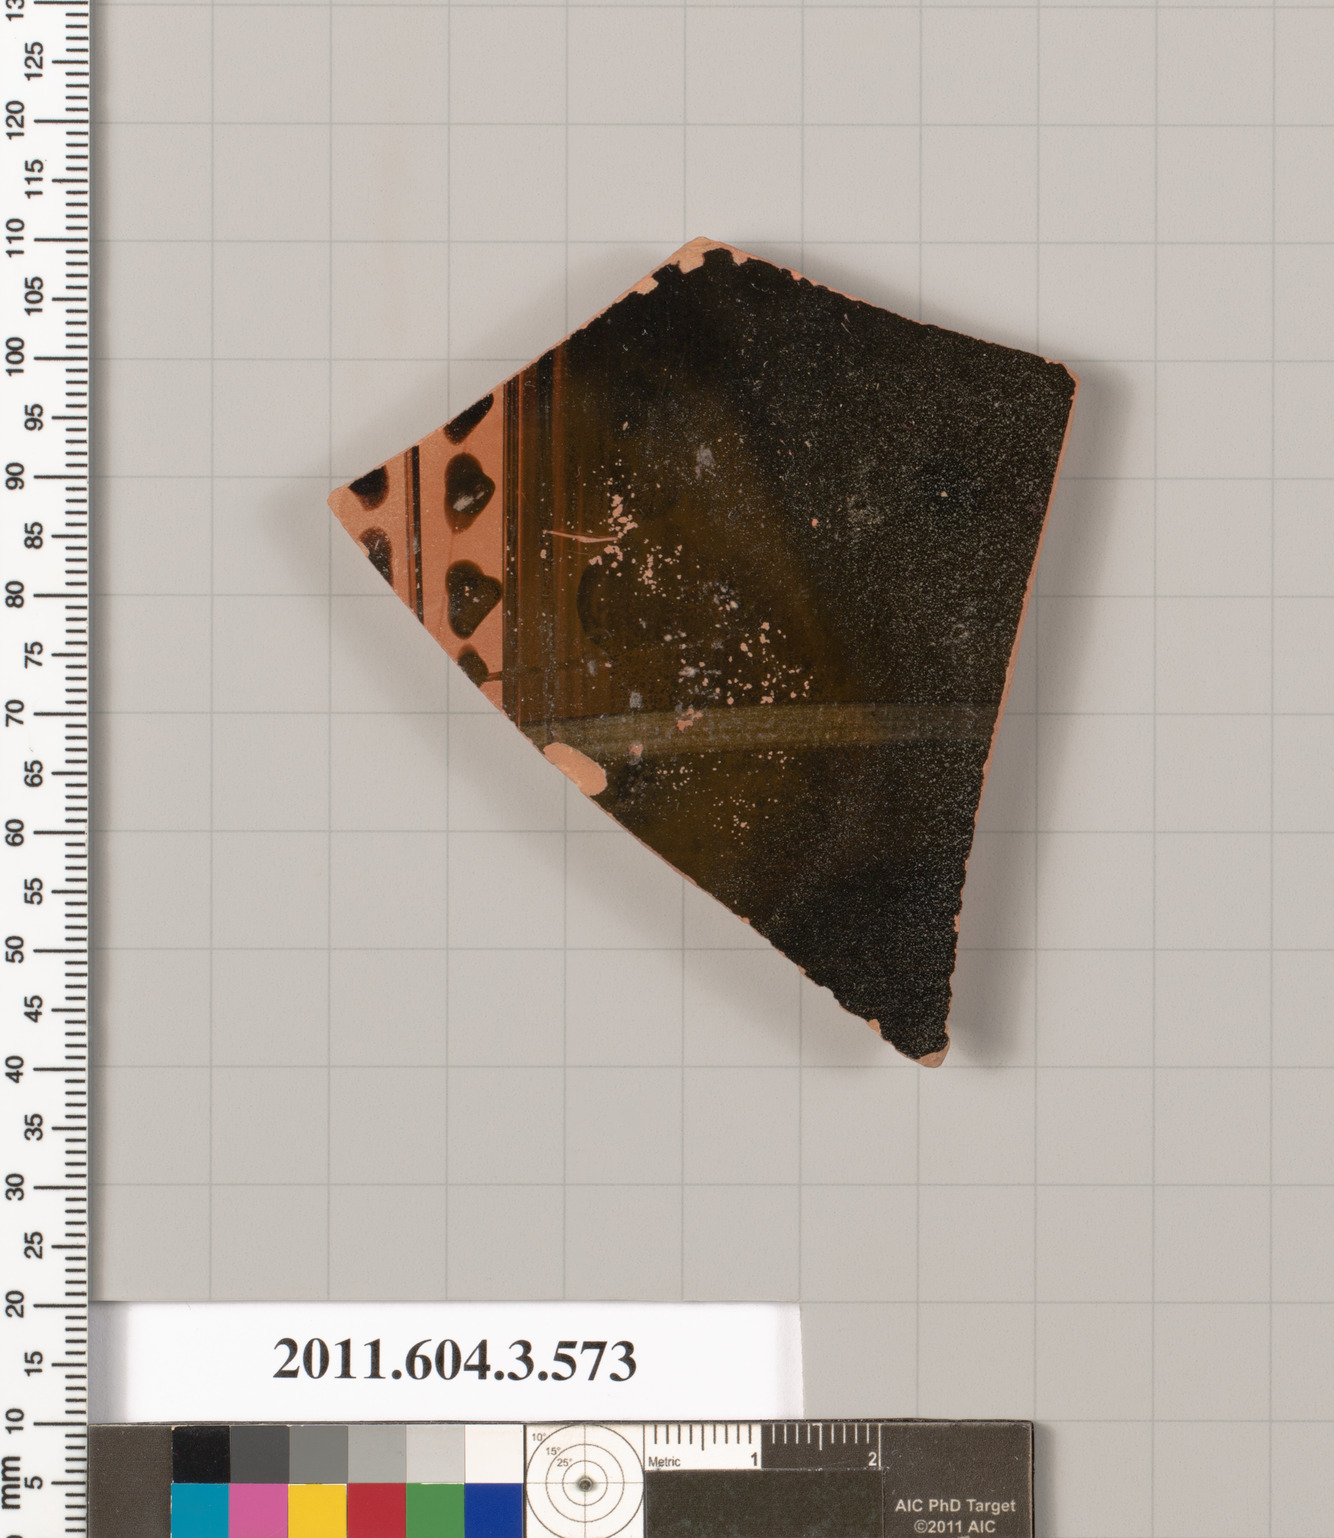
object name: column krater fragment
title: Terracotta fragment of a column-krater (bowl for mixing wine and water)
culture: greek, attic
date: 534-468 BCE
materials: terracotta